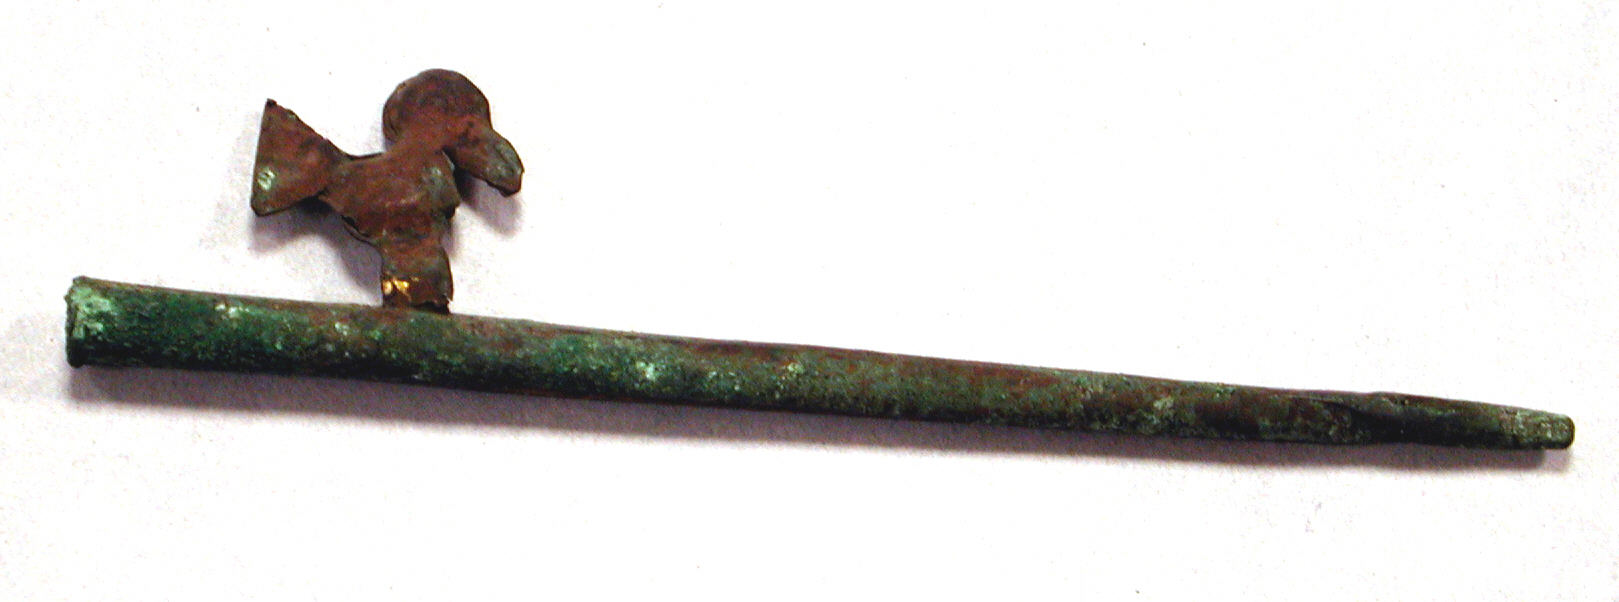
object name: spear thrower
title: Hammered Copper Miniature Spear Thrower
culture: peruvian, north or central coast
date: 701-1566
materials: copper, gilt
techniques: hammering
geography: peru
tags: birds